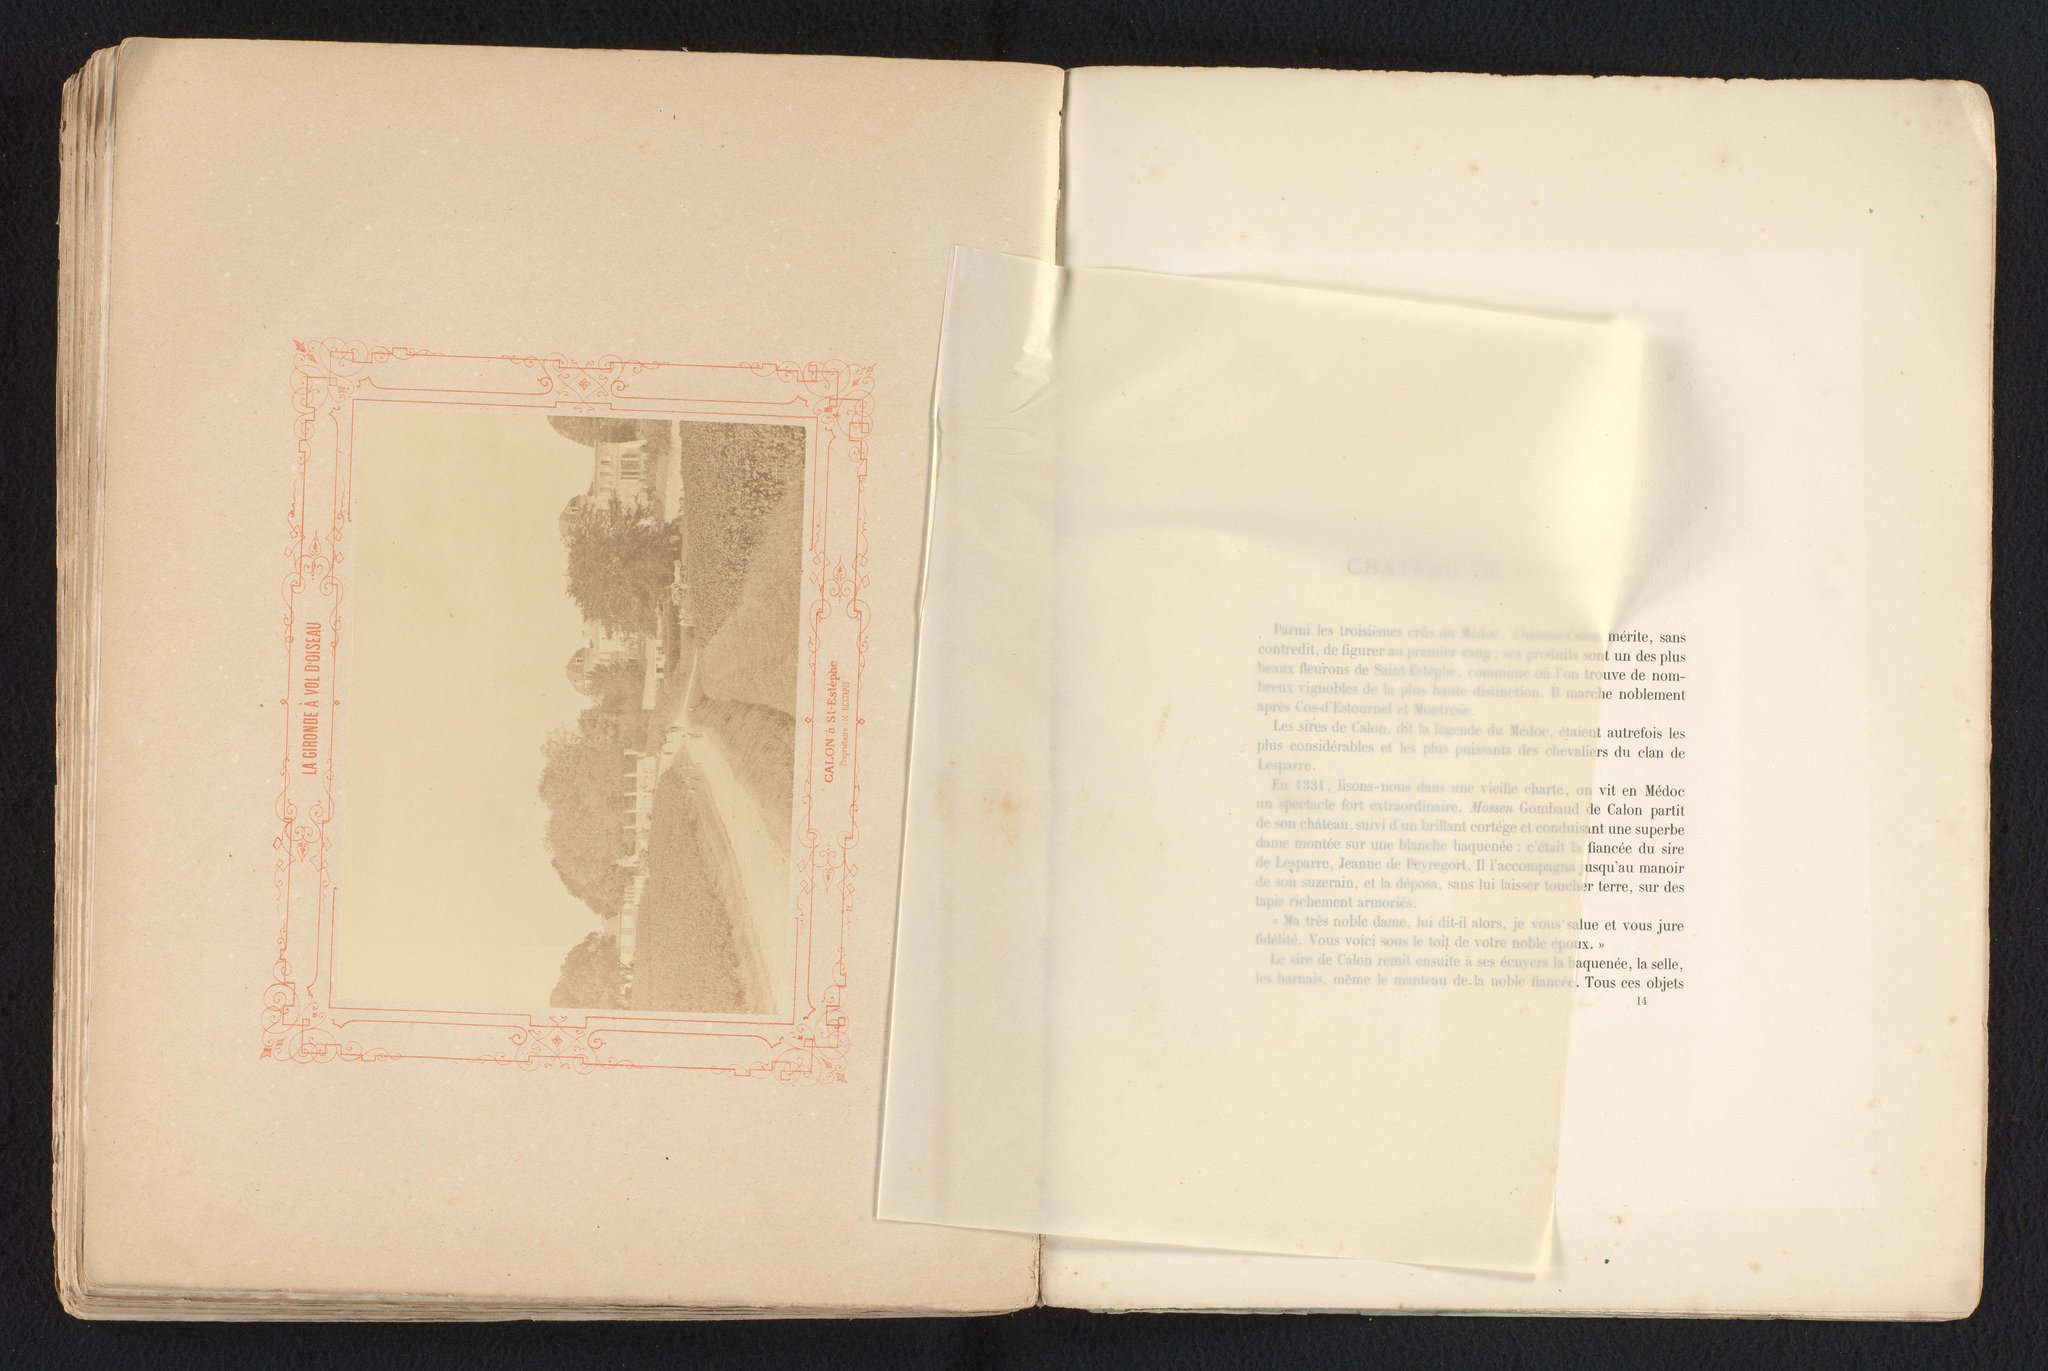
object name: photograph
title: Calon à St-Estèphe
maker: alfred danflou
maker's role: fotograaf, schrijver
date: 1862-1867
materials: paper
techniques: albumen print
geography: saint-estèphe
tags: castle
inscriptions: inscription: ‘propriétaire: M. LESTAPIS.’